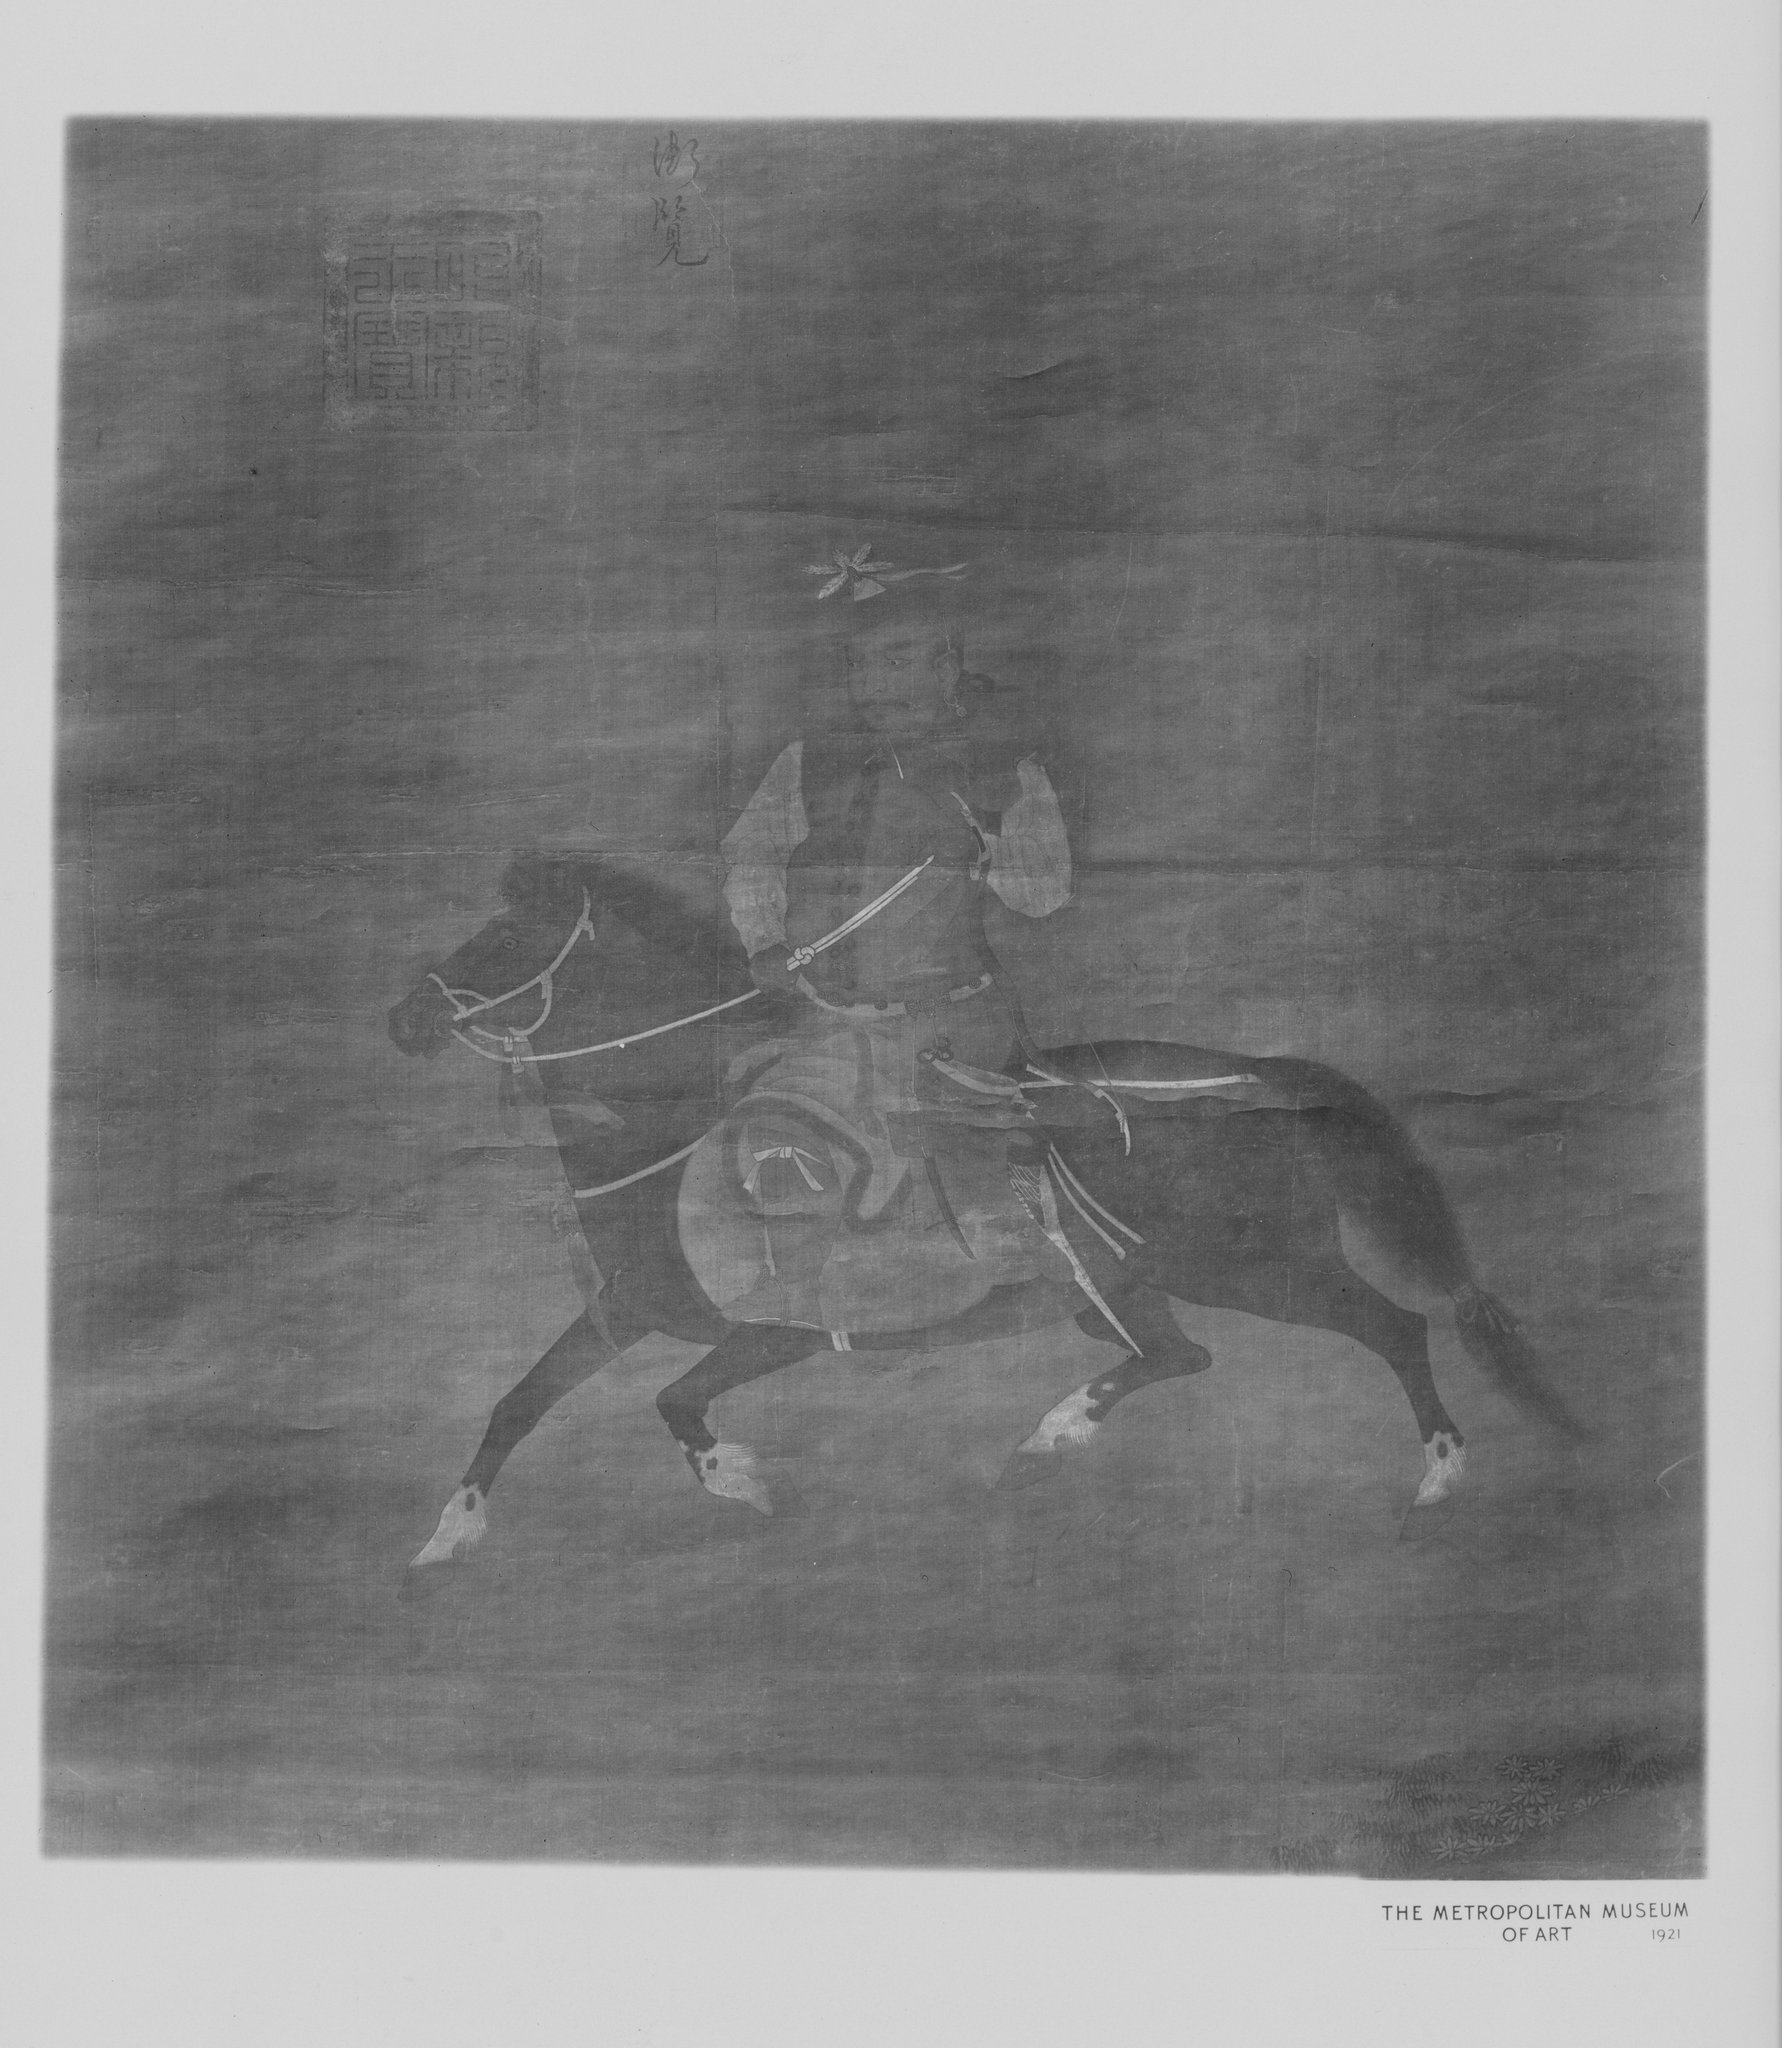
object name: hanging scroll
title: Tangut Horseman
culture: chinese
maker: unidentified artist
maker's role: artist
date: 1368-1700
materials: ink, silk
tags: men,horses